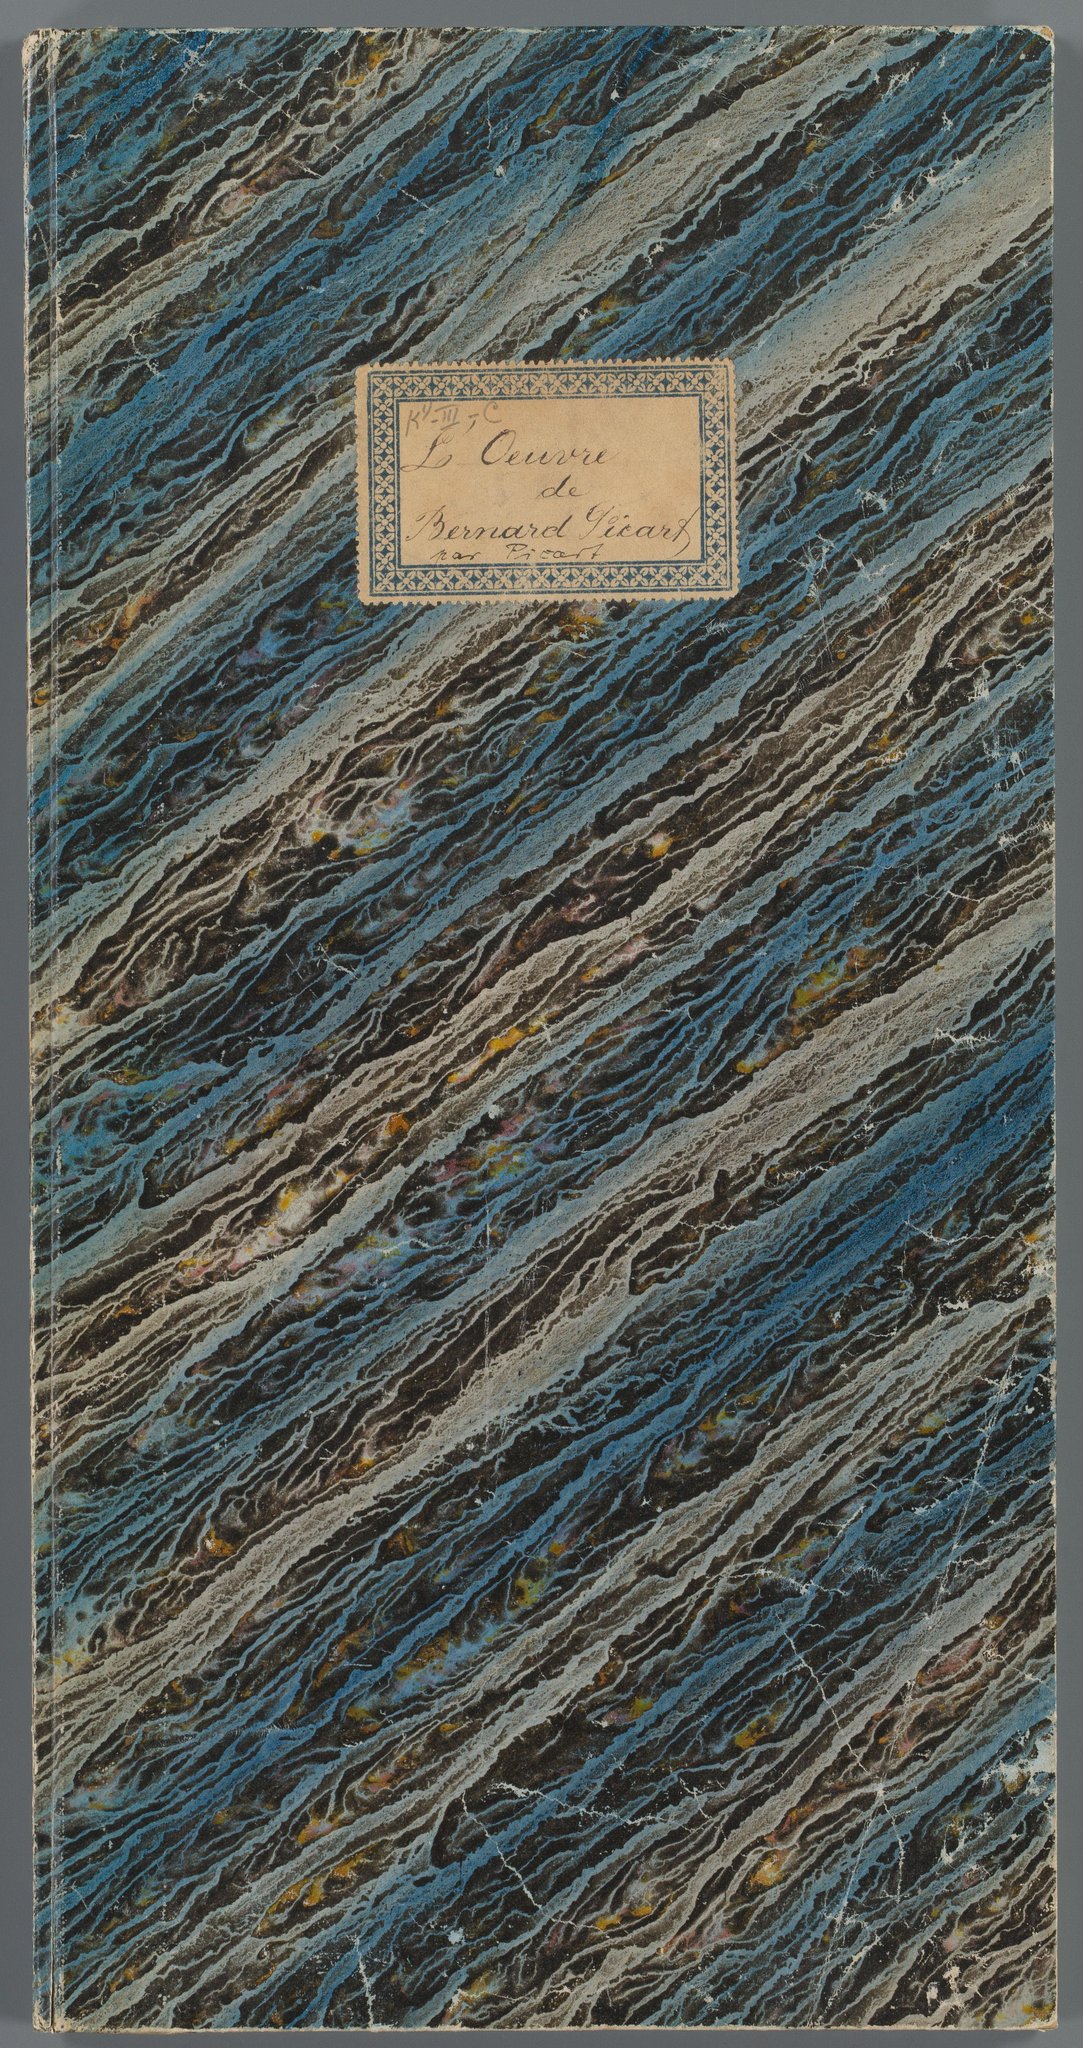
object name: manuscript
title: Catalogue des pièces qui composent l'oeuvre de Bernard Picart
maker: bernard picart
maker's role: draughtsman, print maker, publisher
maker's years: 1673-1733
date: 1683-1733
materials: ink, paper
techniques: pen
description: L'oeuvre de Bernard Picart, door Bernard Picart & Veuve B. Picart: catalogue des pièces qui composent l'oeuvre de Bernard Picart, dessinateur et graveur. Door Picart zelf opgemaakt. Handschrift in pen in bruin. Folio in band bekleed met blauw-grijs sierpapier.